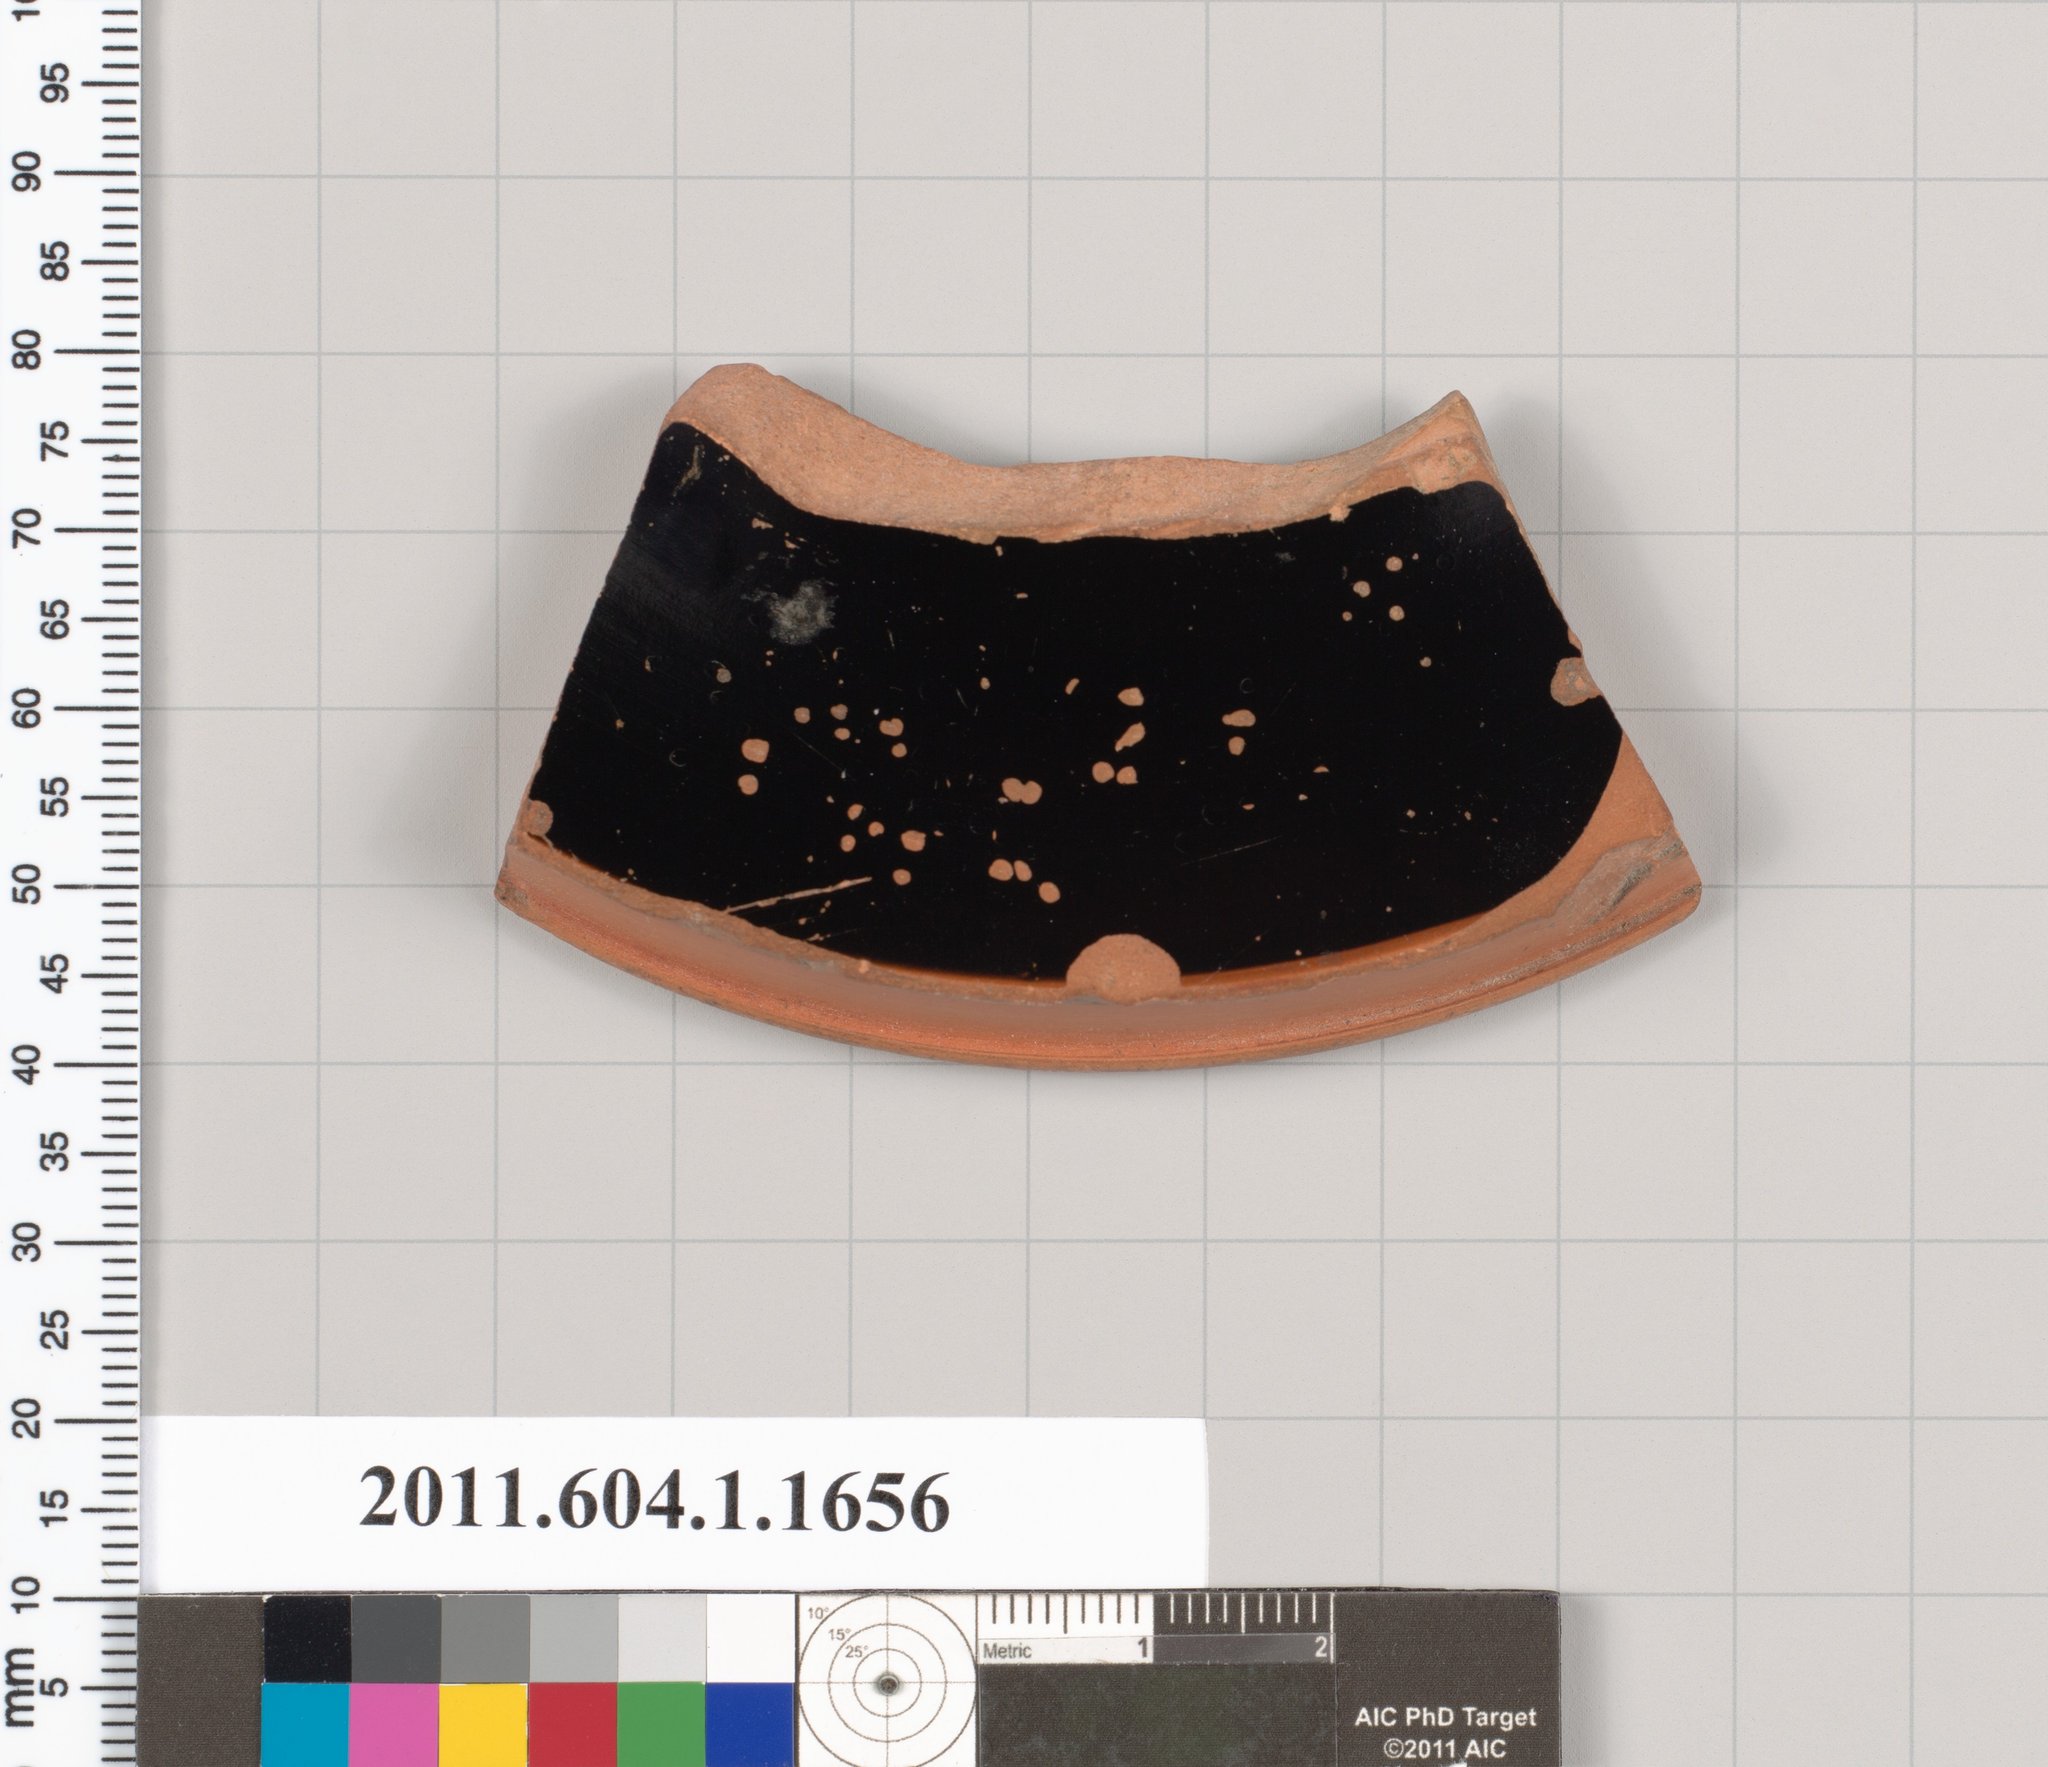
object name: kylix fragment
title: Terracotta fragment of a kylix (drinking cup)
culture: greek, attic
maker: hischylos painter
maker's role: artist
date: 530-510 BCE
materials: terracotta